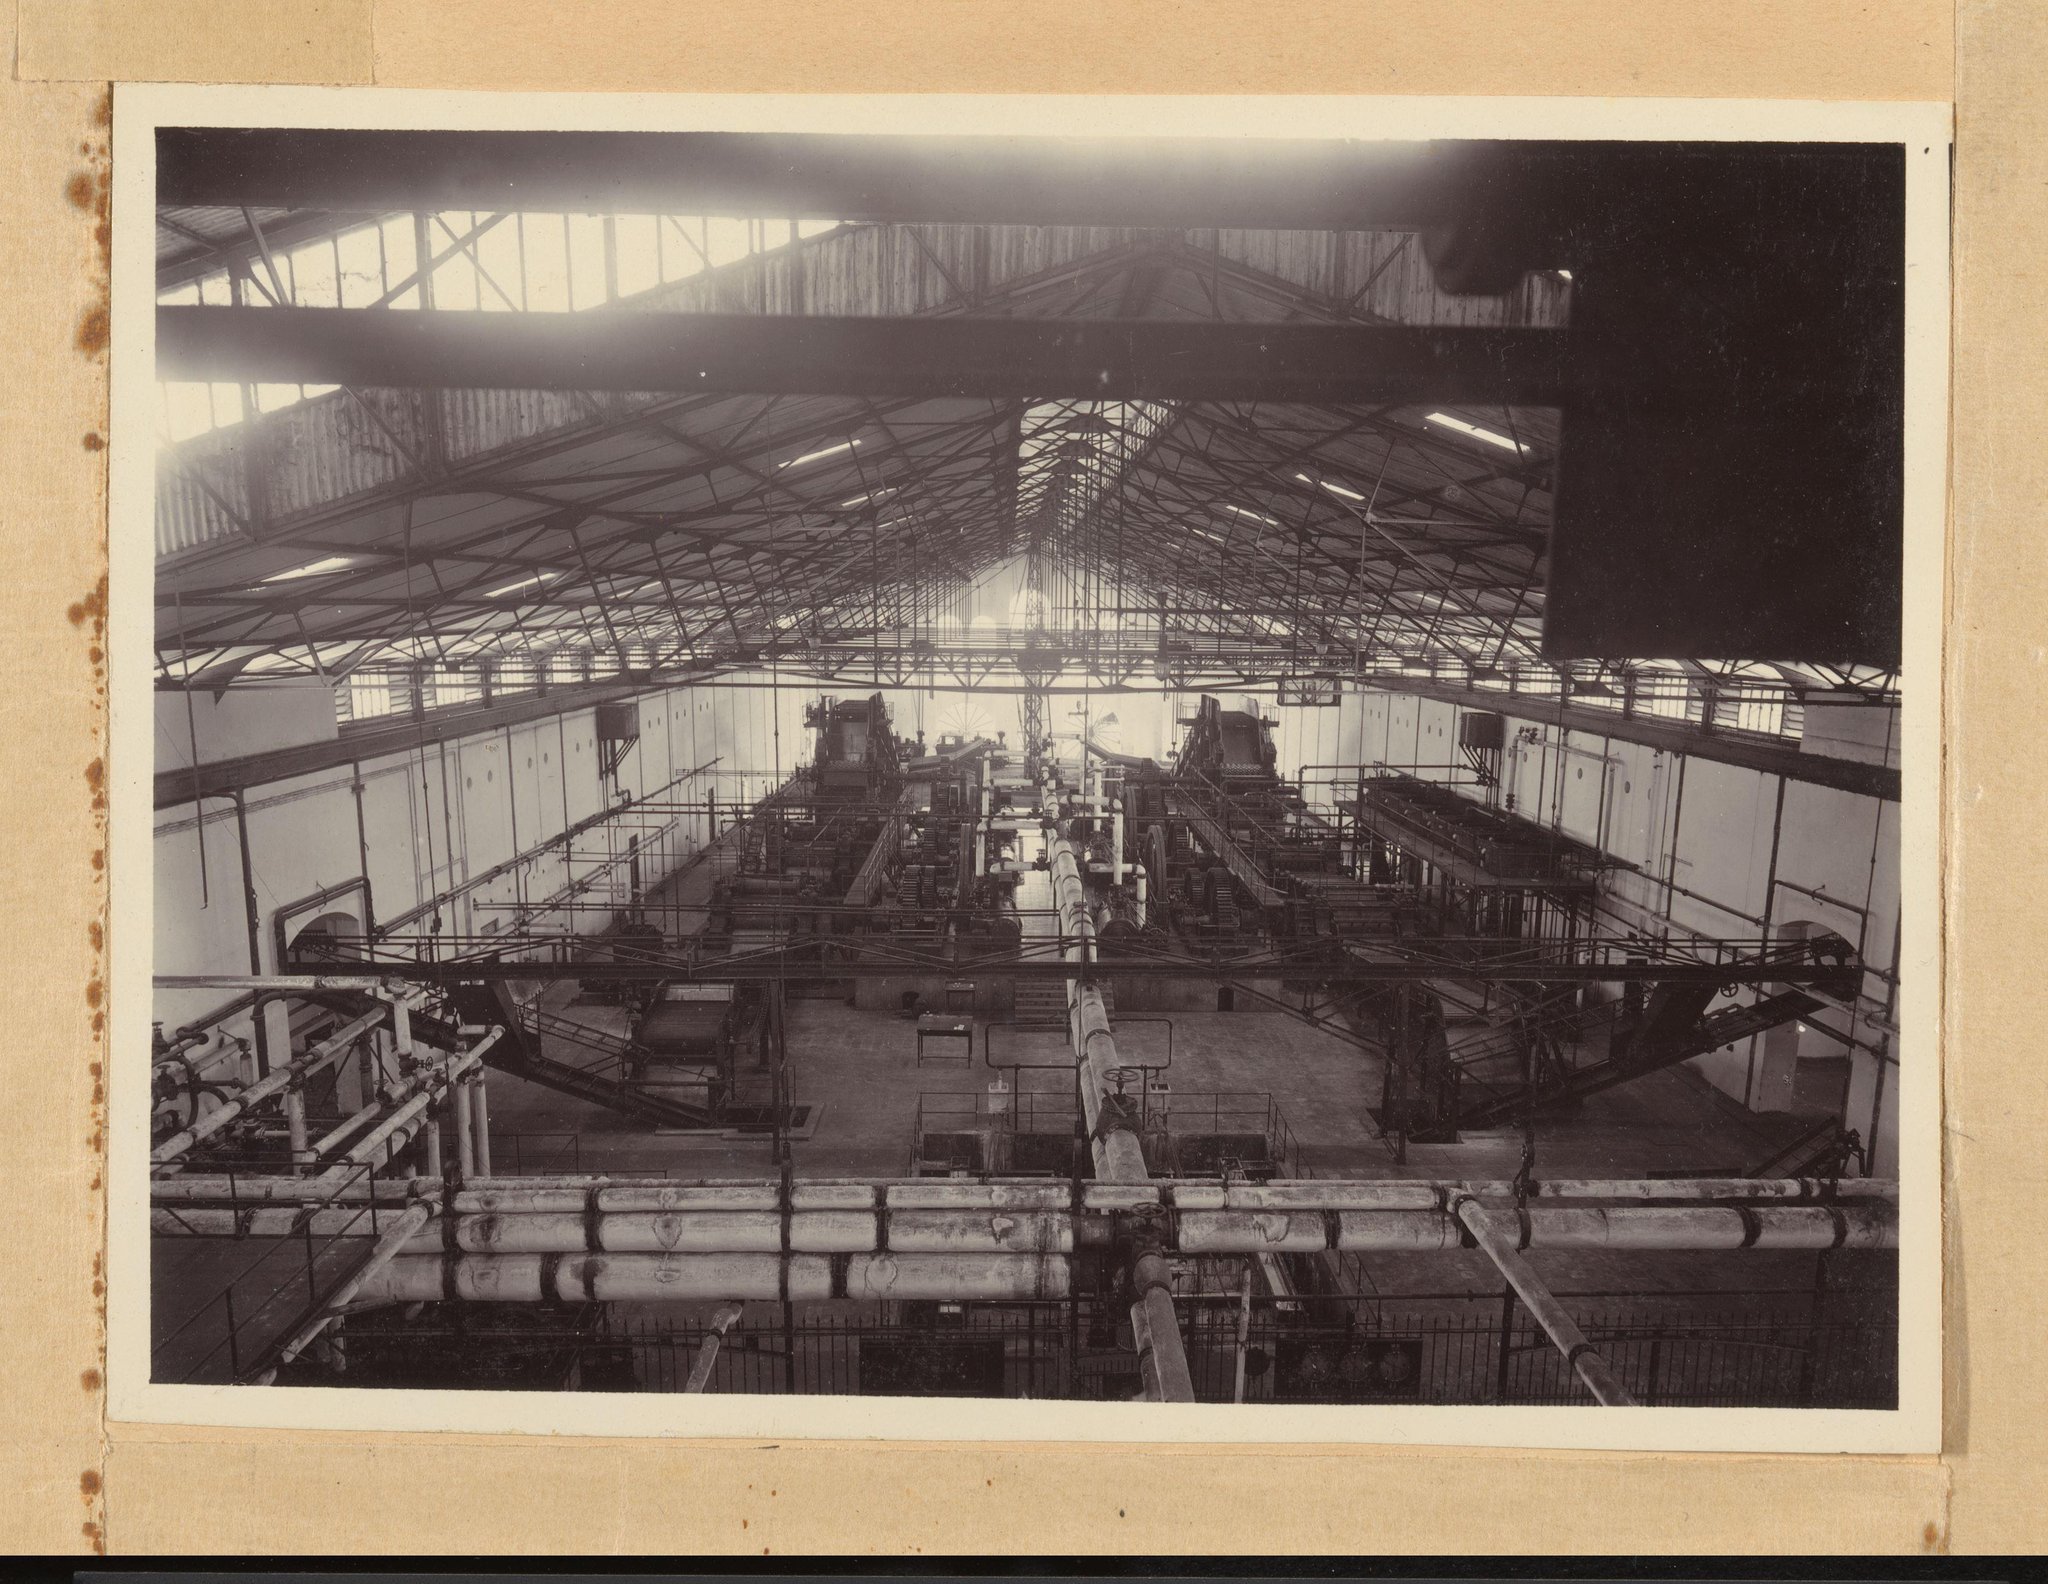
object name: photograph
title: Exterieur van een suikerfabriek, een spoorwegemplacement en hijskraan in Purworejo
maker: Anonymous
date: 1916-1918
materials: photographic support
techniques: gelatin silver print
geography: purworejo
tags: factory-building, vertical transport, hoisting (industrial processes), railway, train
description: Onderdeel van Familiealbum met foto's van een familie in de voormalige kolonie Nederlands-Indië en van een suikerfabriek in Purworejo.